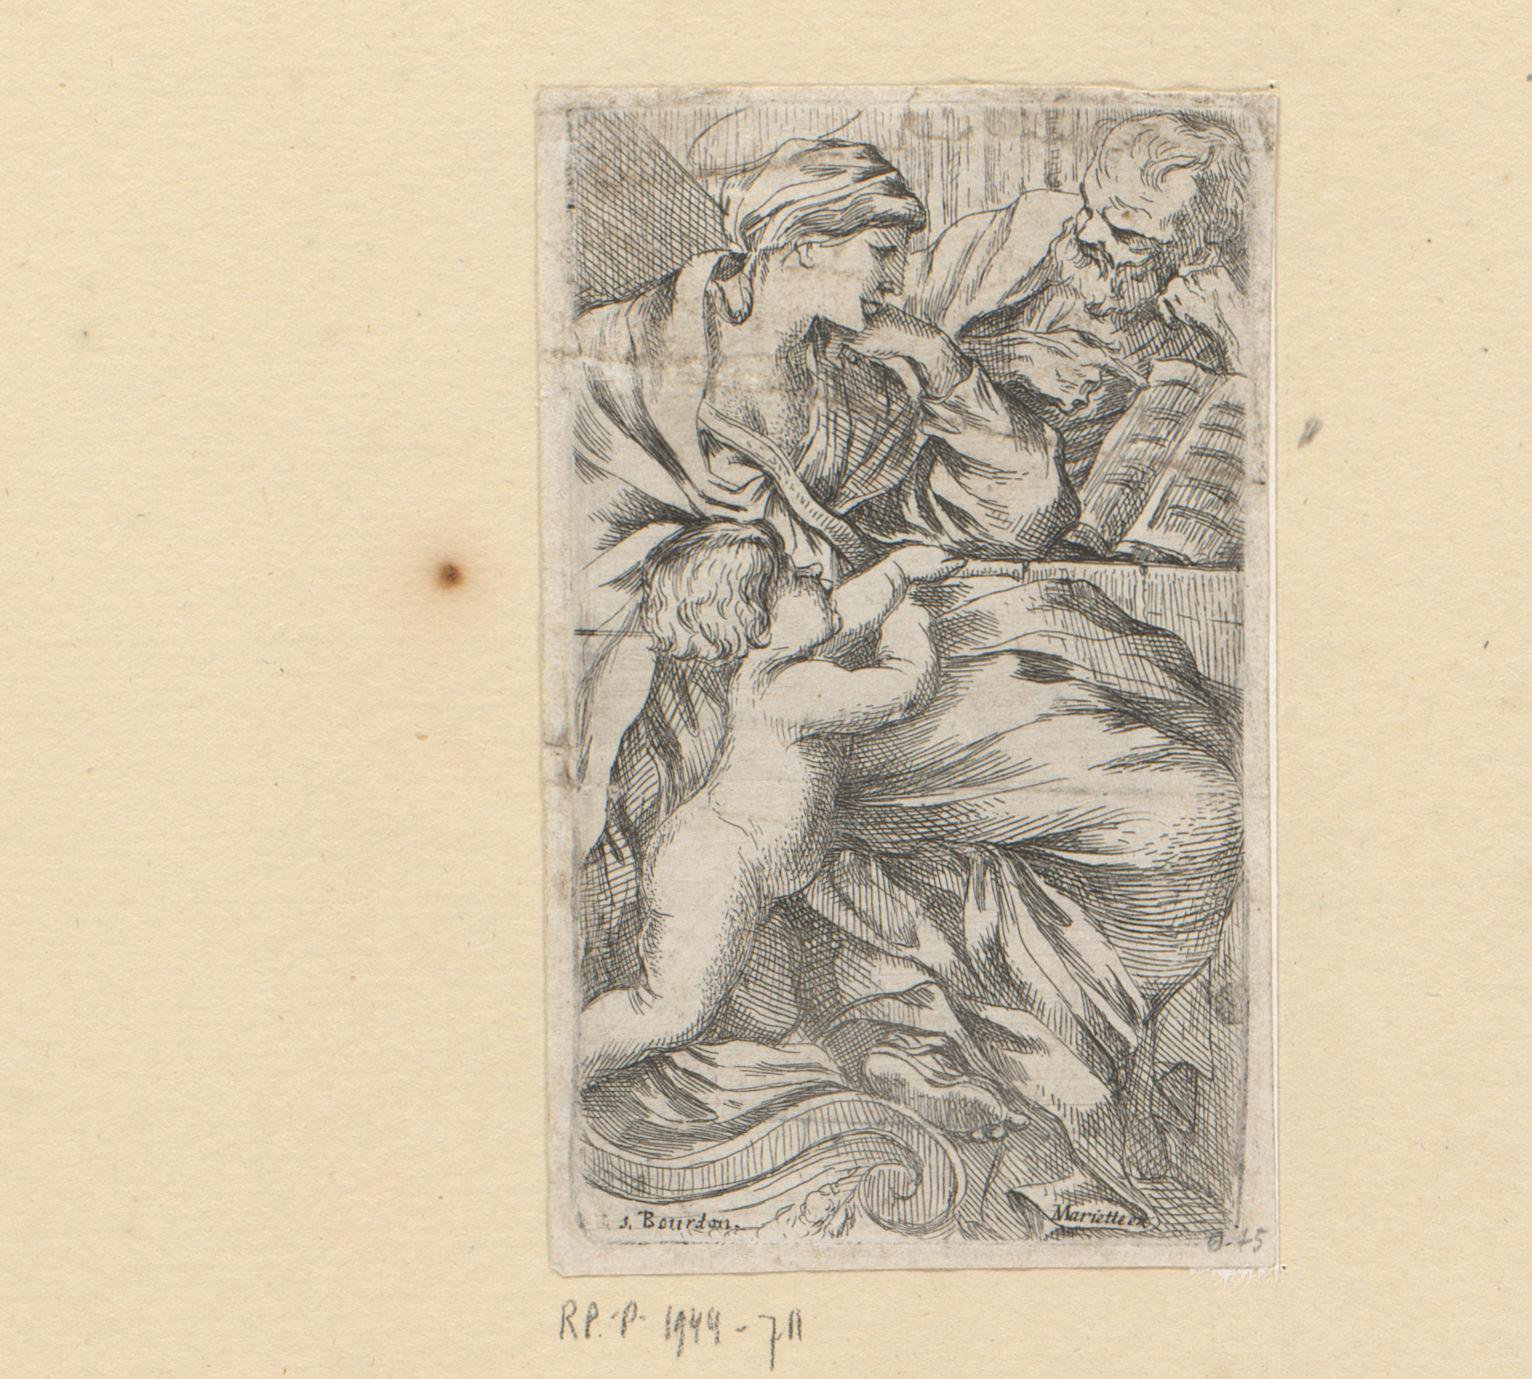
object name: print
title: Heilige Familie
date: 1626-1657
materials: paper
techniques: etching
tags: holy family, and derived representations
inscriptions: collector's mark: Lugt 789a, collector's mark: Lugt 2228